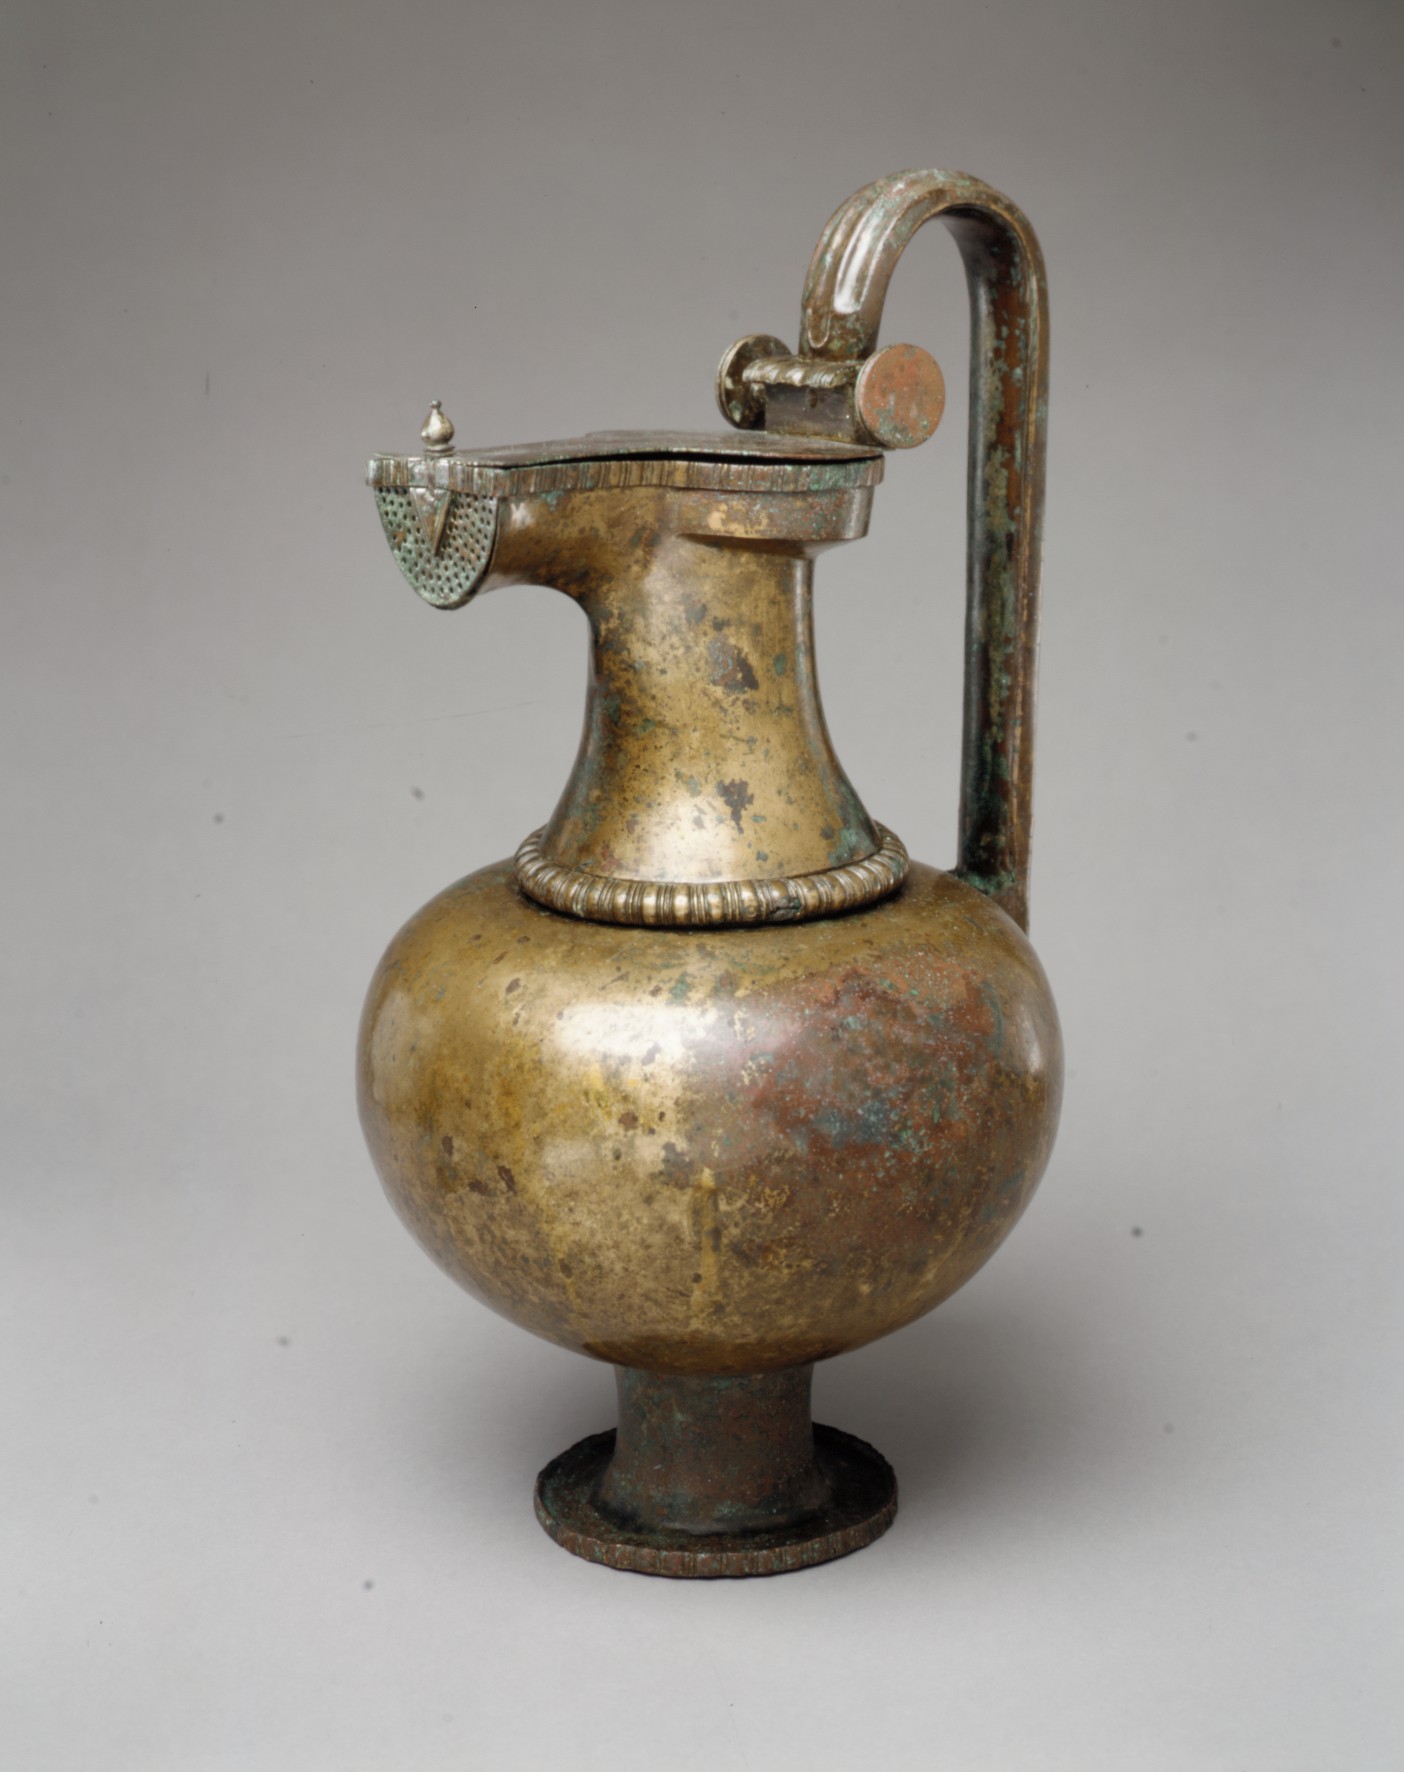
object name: jug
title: Bronze jug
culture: east greek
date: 600-468 BCE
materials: bronze